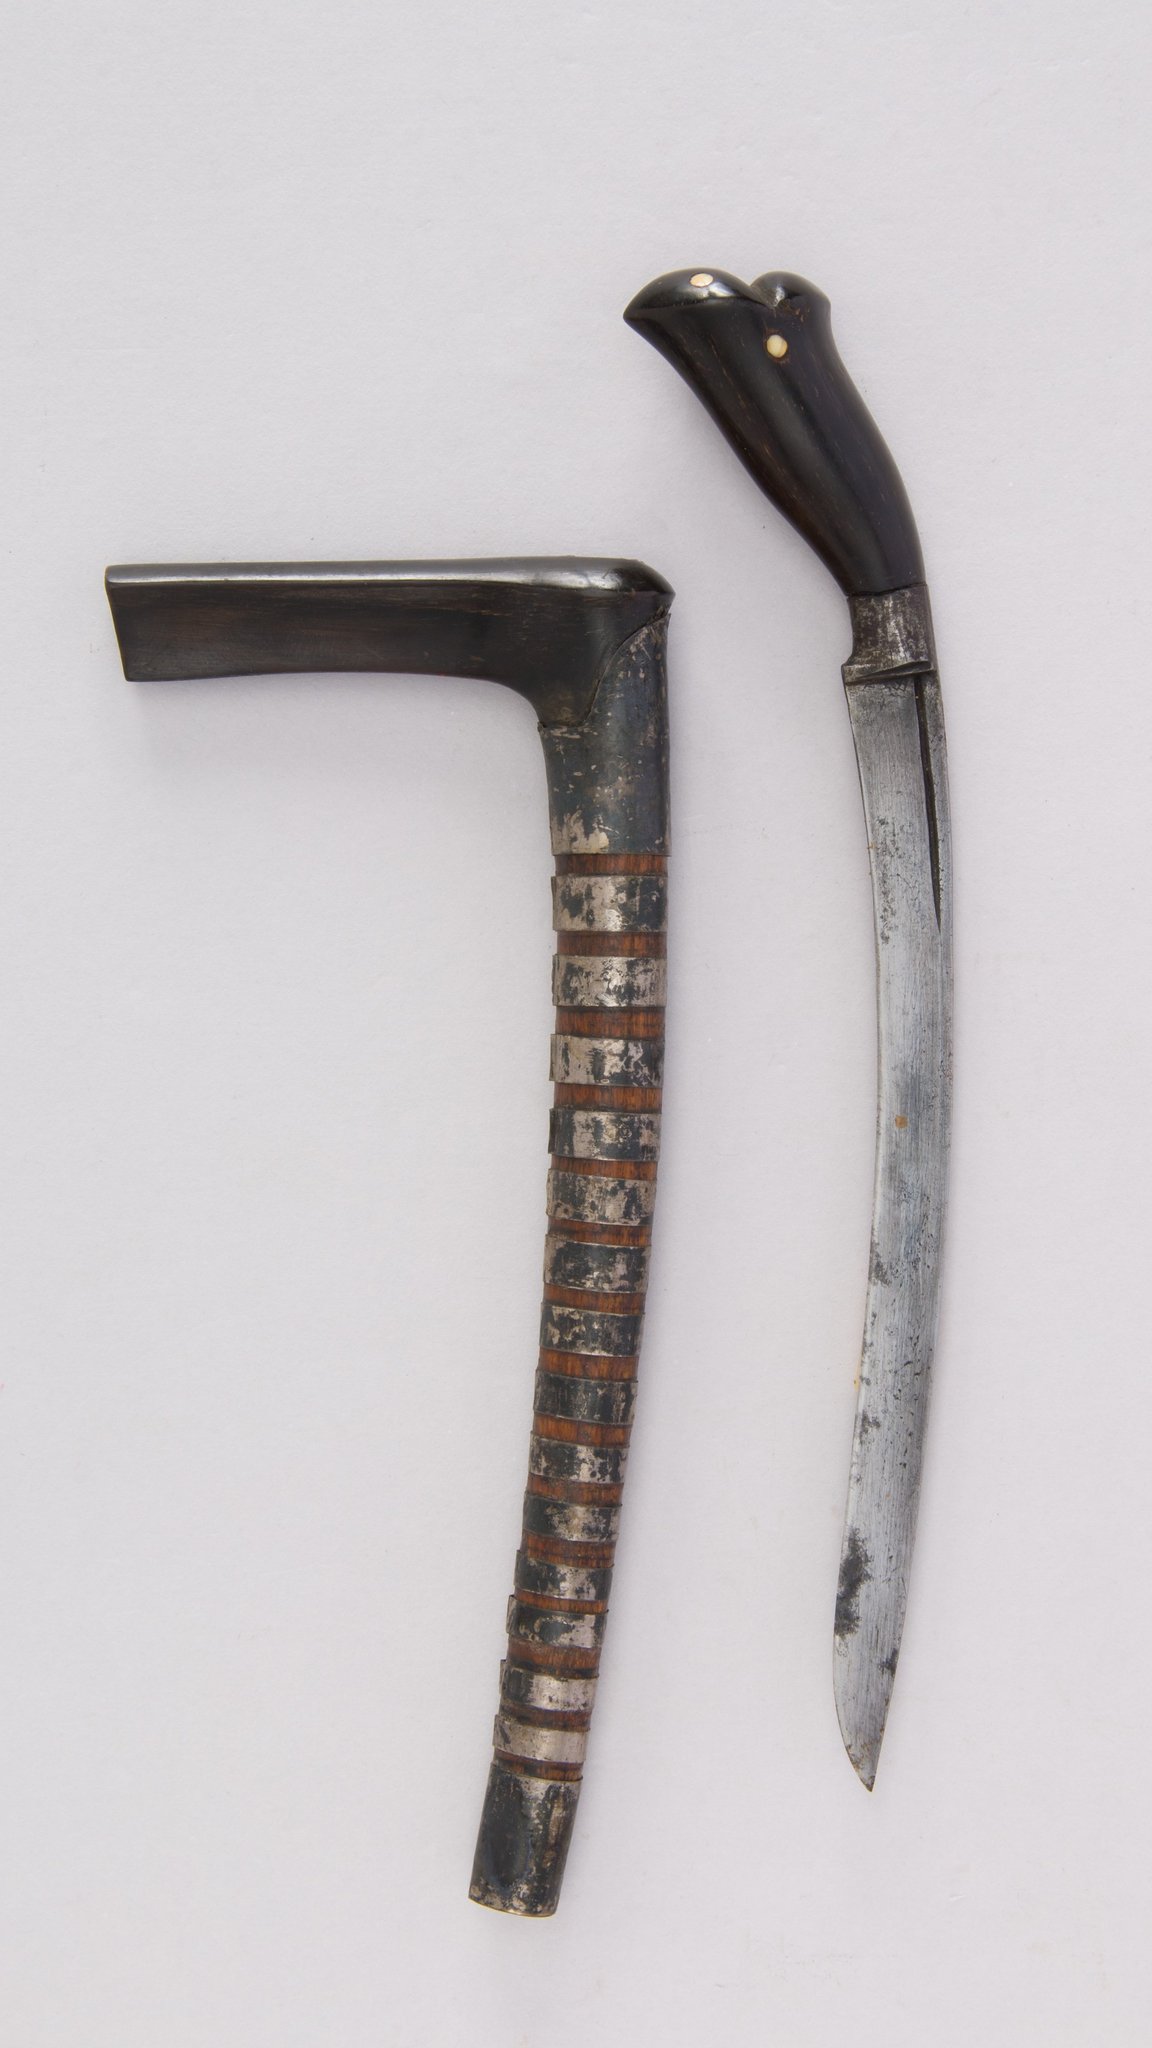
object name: knife bade bade with sheath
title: Knife (Bade-bade) with Sheath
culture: malayan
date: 1701-1900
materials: bone, horn, silver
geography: malaysia